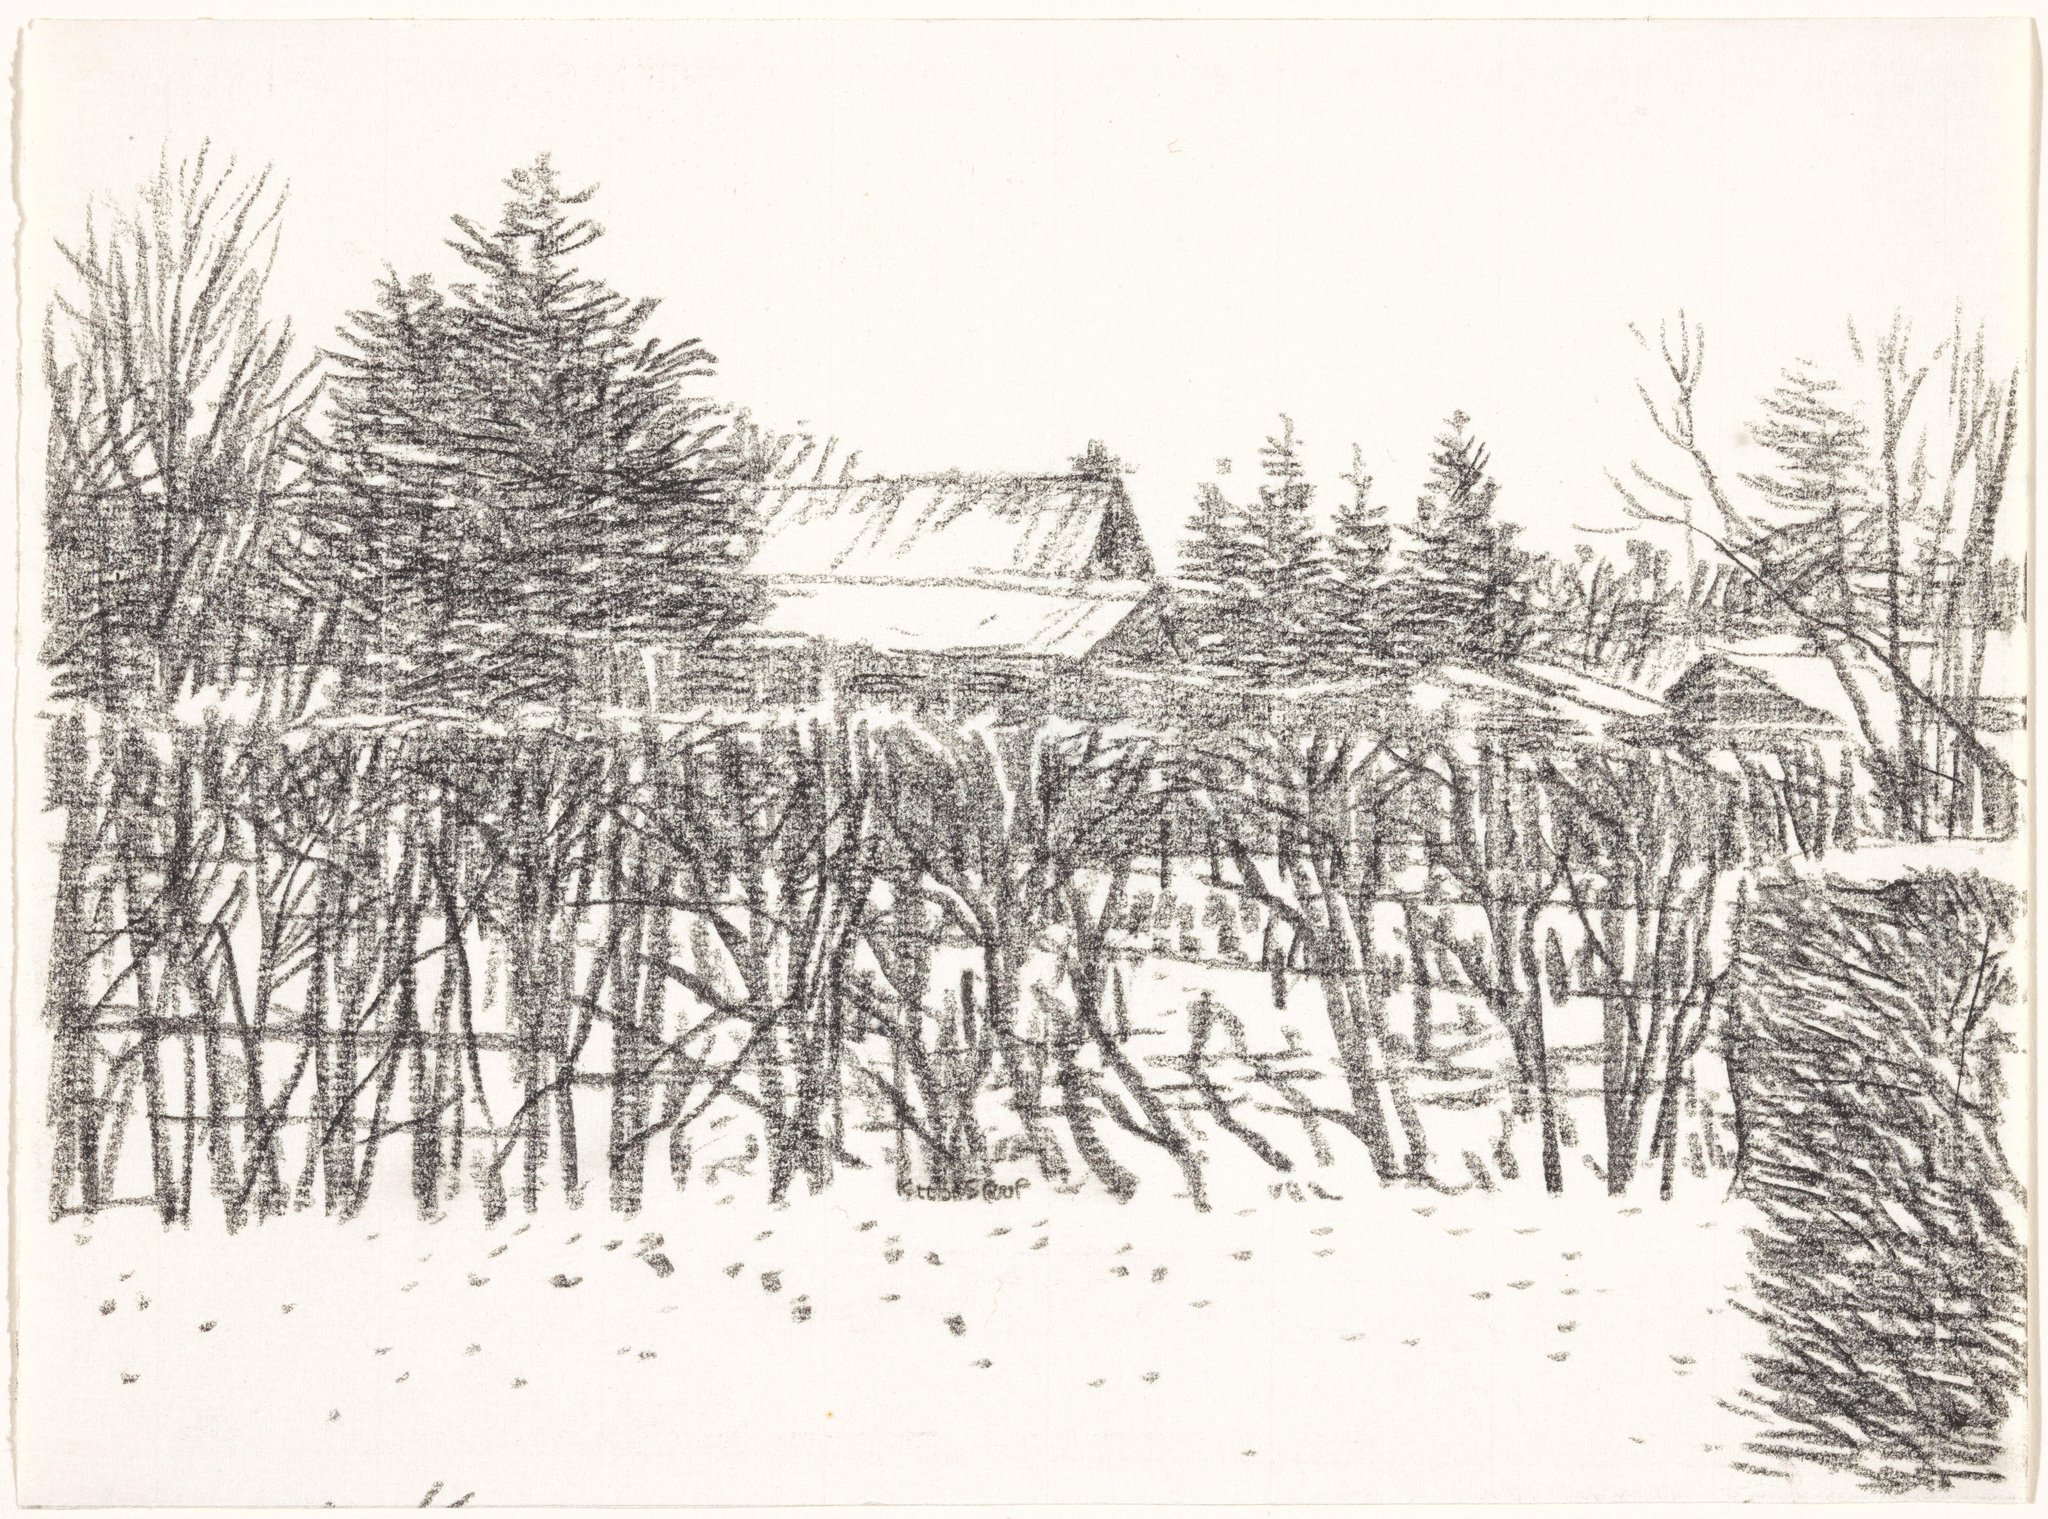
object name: drawing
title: Haag met bomen en schuren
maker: kees stoop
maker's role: draughtsman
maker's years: 1929-2019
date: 1939-2009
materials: charcoal, paper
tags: farm or solitary house in landscape